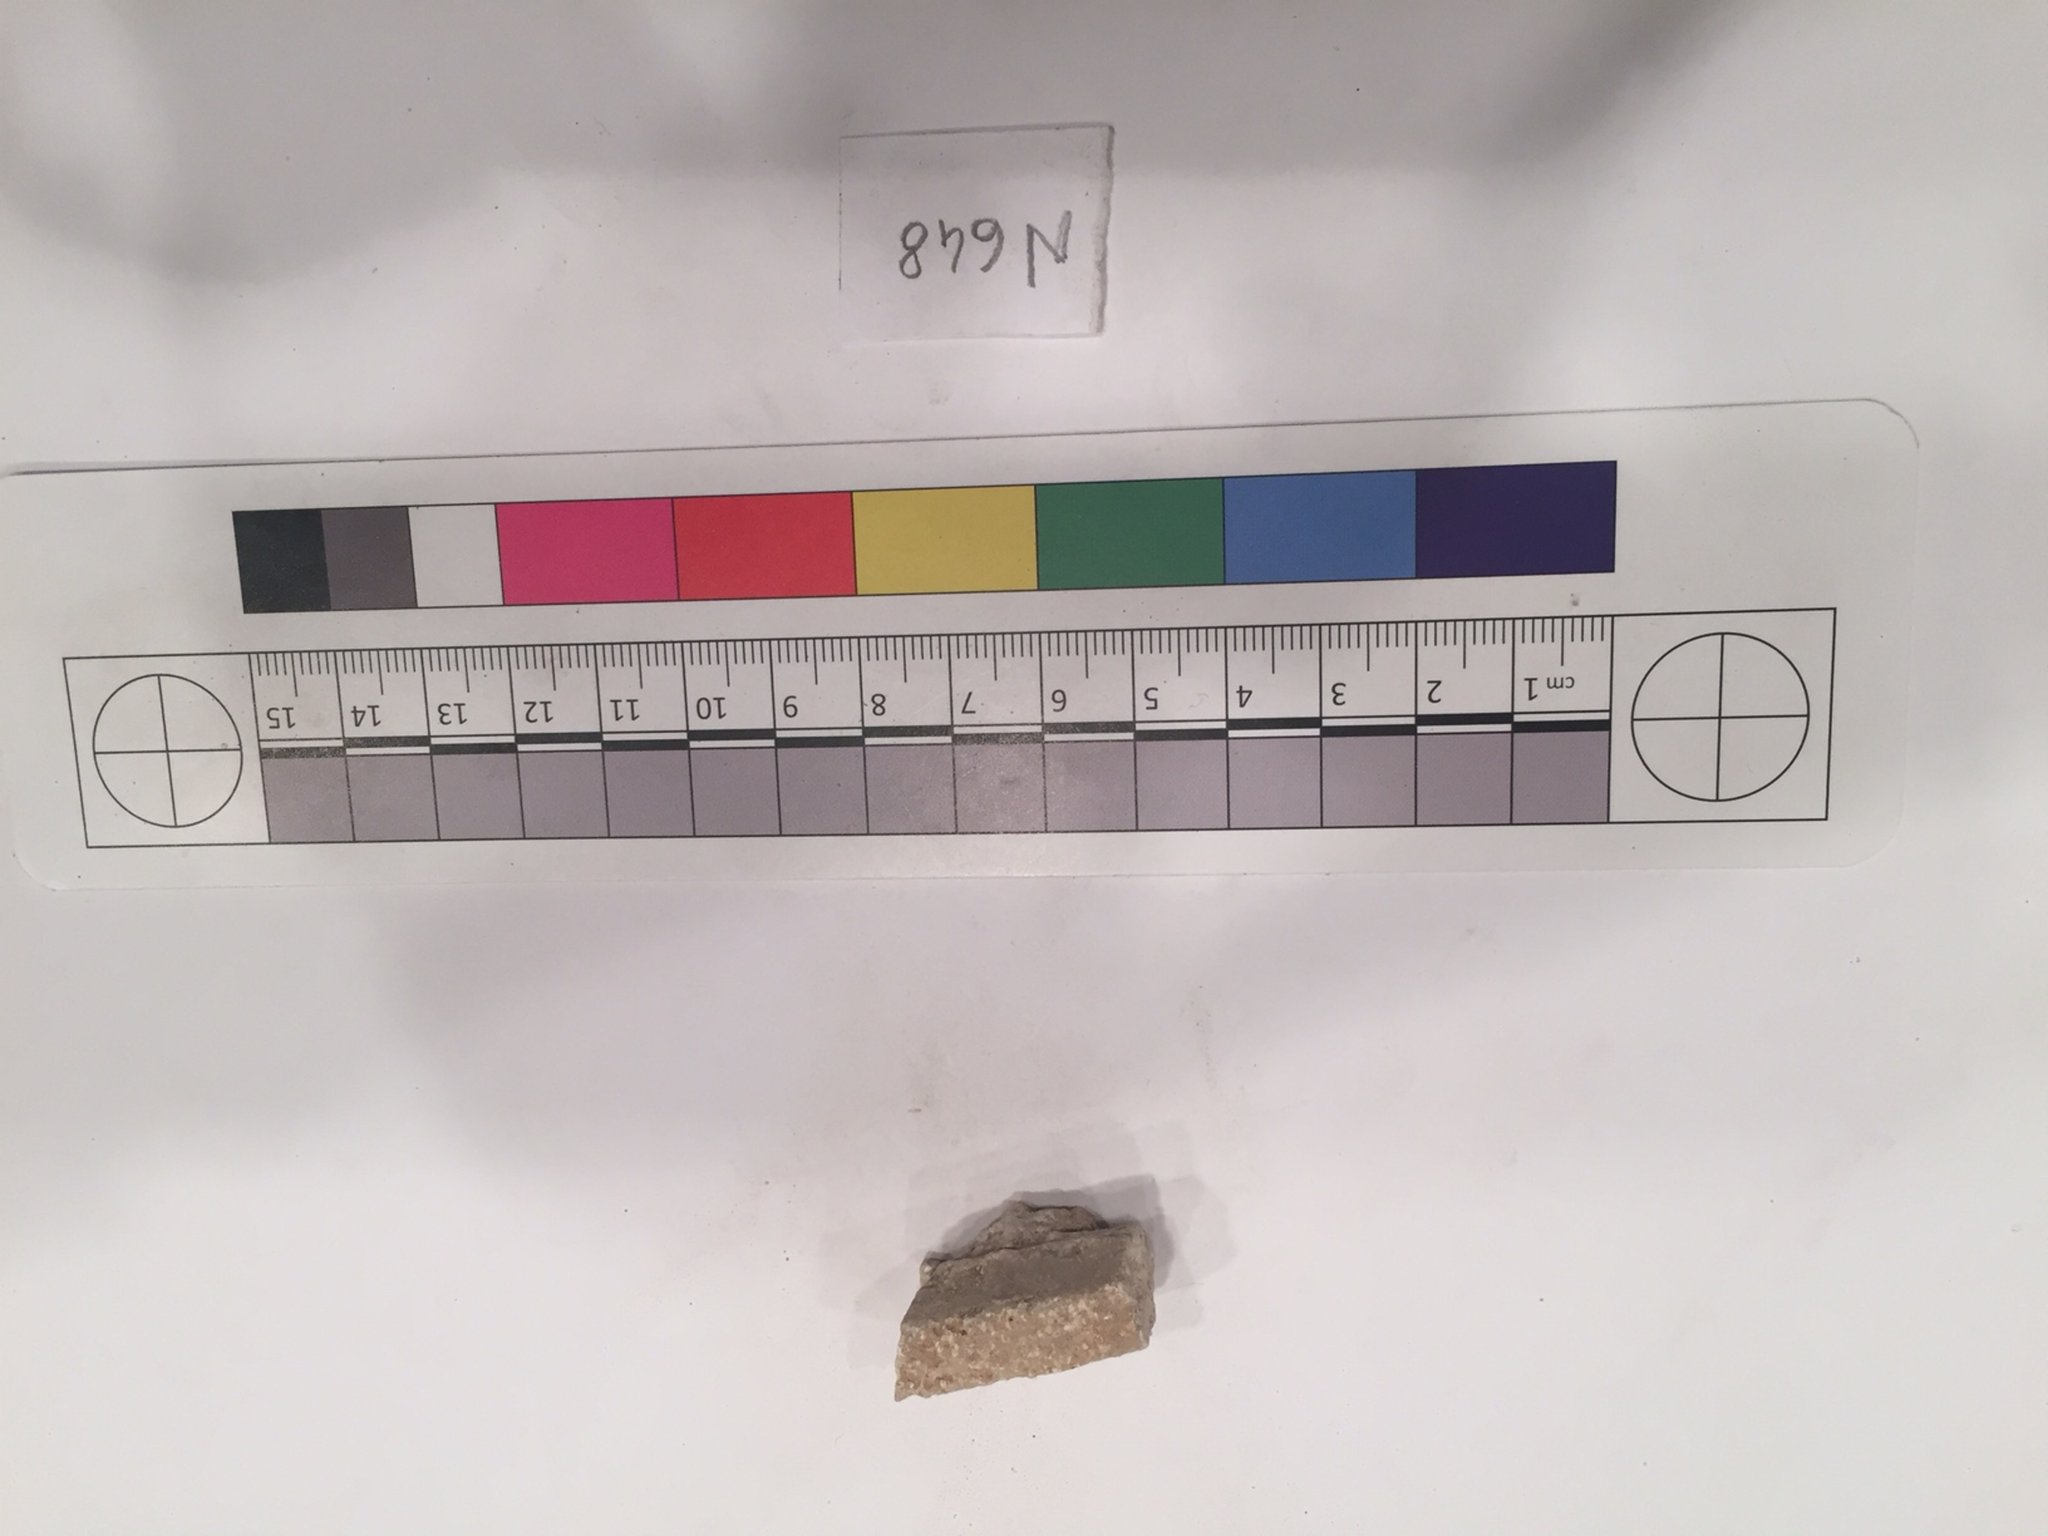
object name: fragment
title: Stucco Fragment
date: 701-1200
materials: plaster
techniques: carving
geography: iran